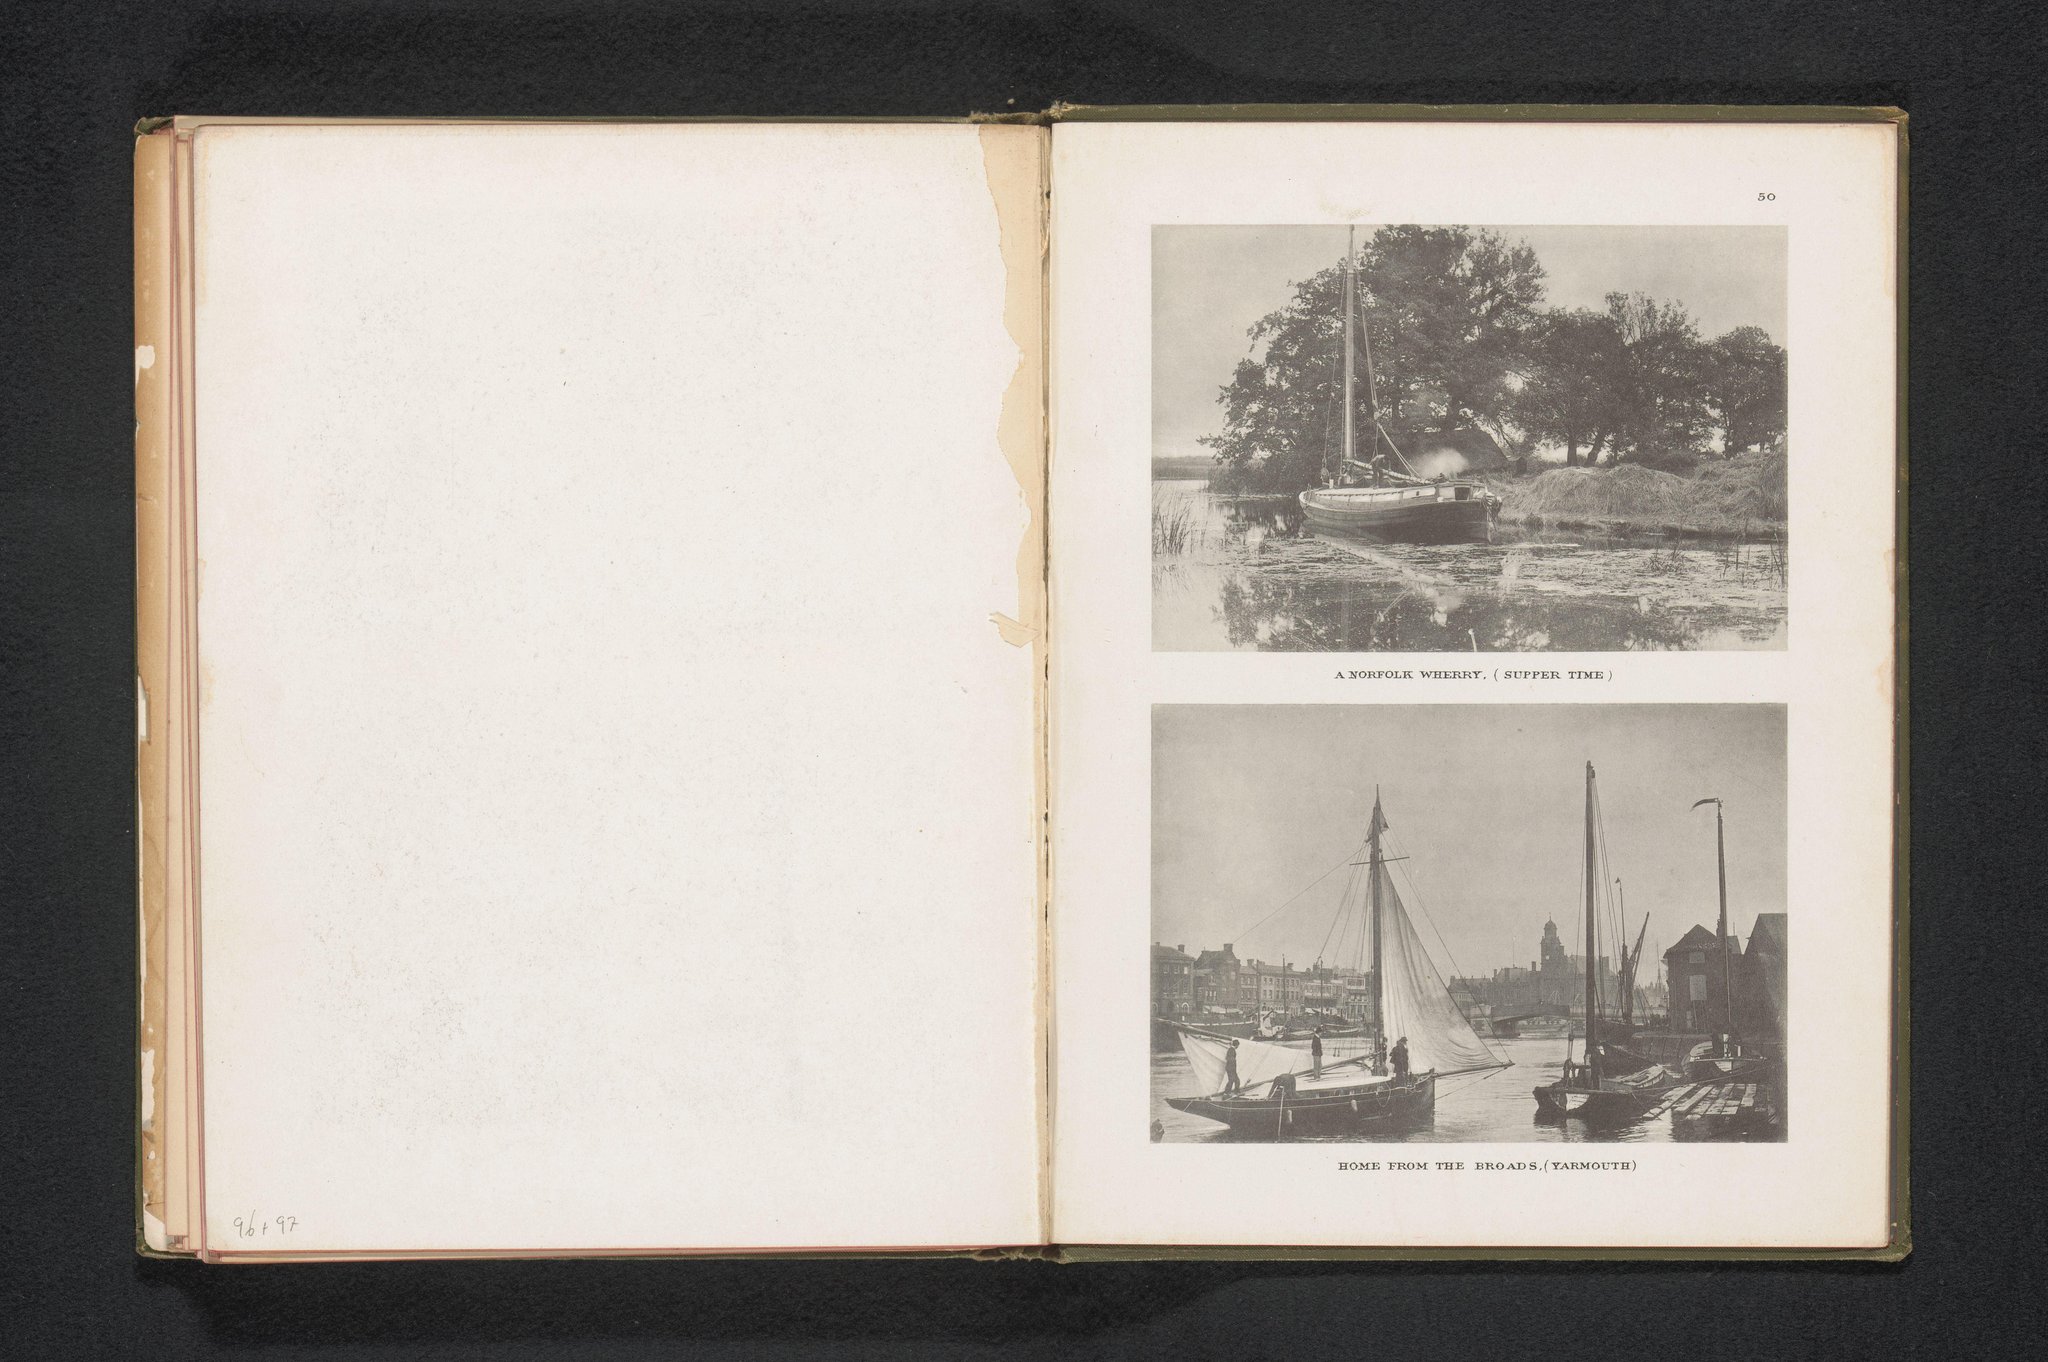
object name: photomechanical print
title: Gezicht op een wherry langs de oever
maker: john payne jennings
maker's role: fotograaf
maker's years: 1843-1926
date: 1886-1891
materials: paper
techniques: photograph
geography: norfolk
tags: sailing-ship, sailing-boat, river